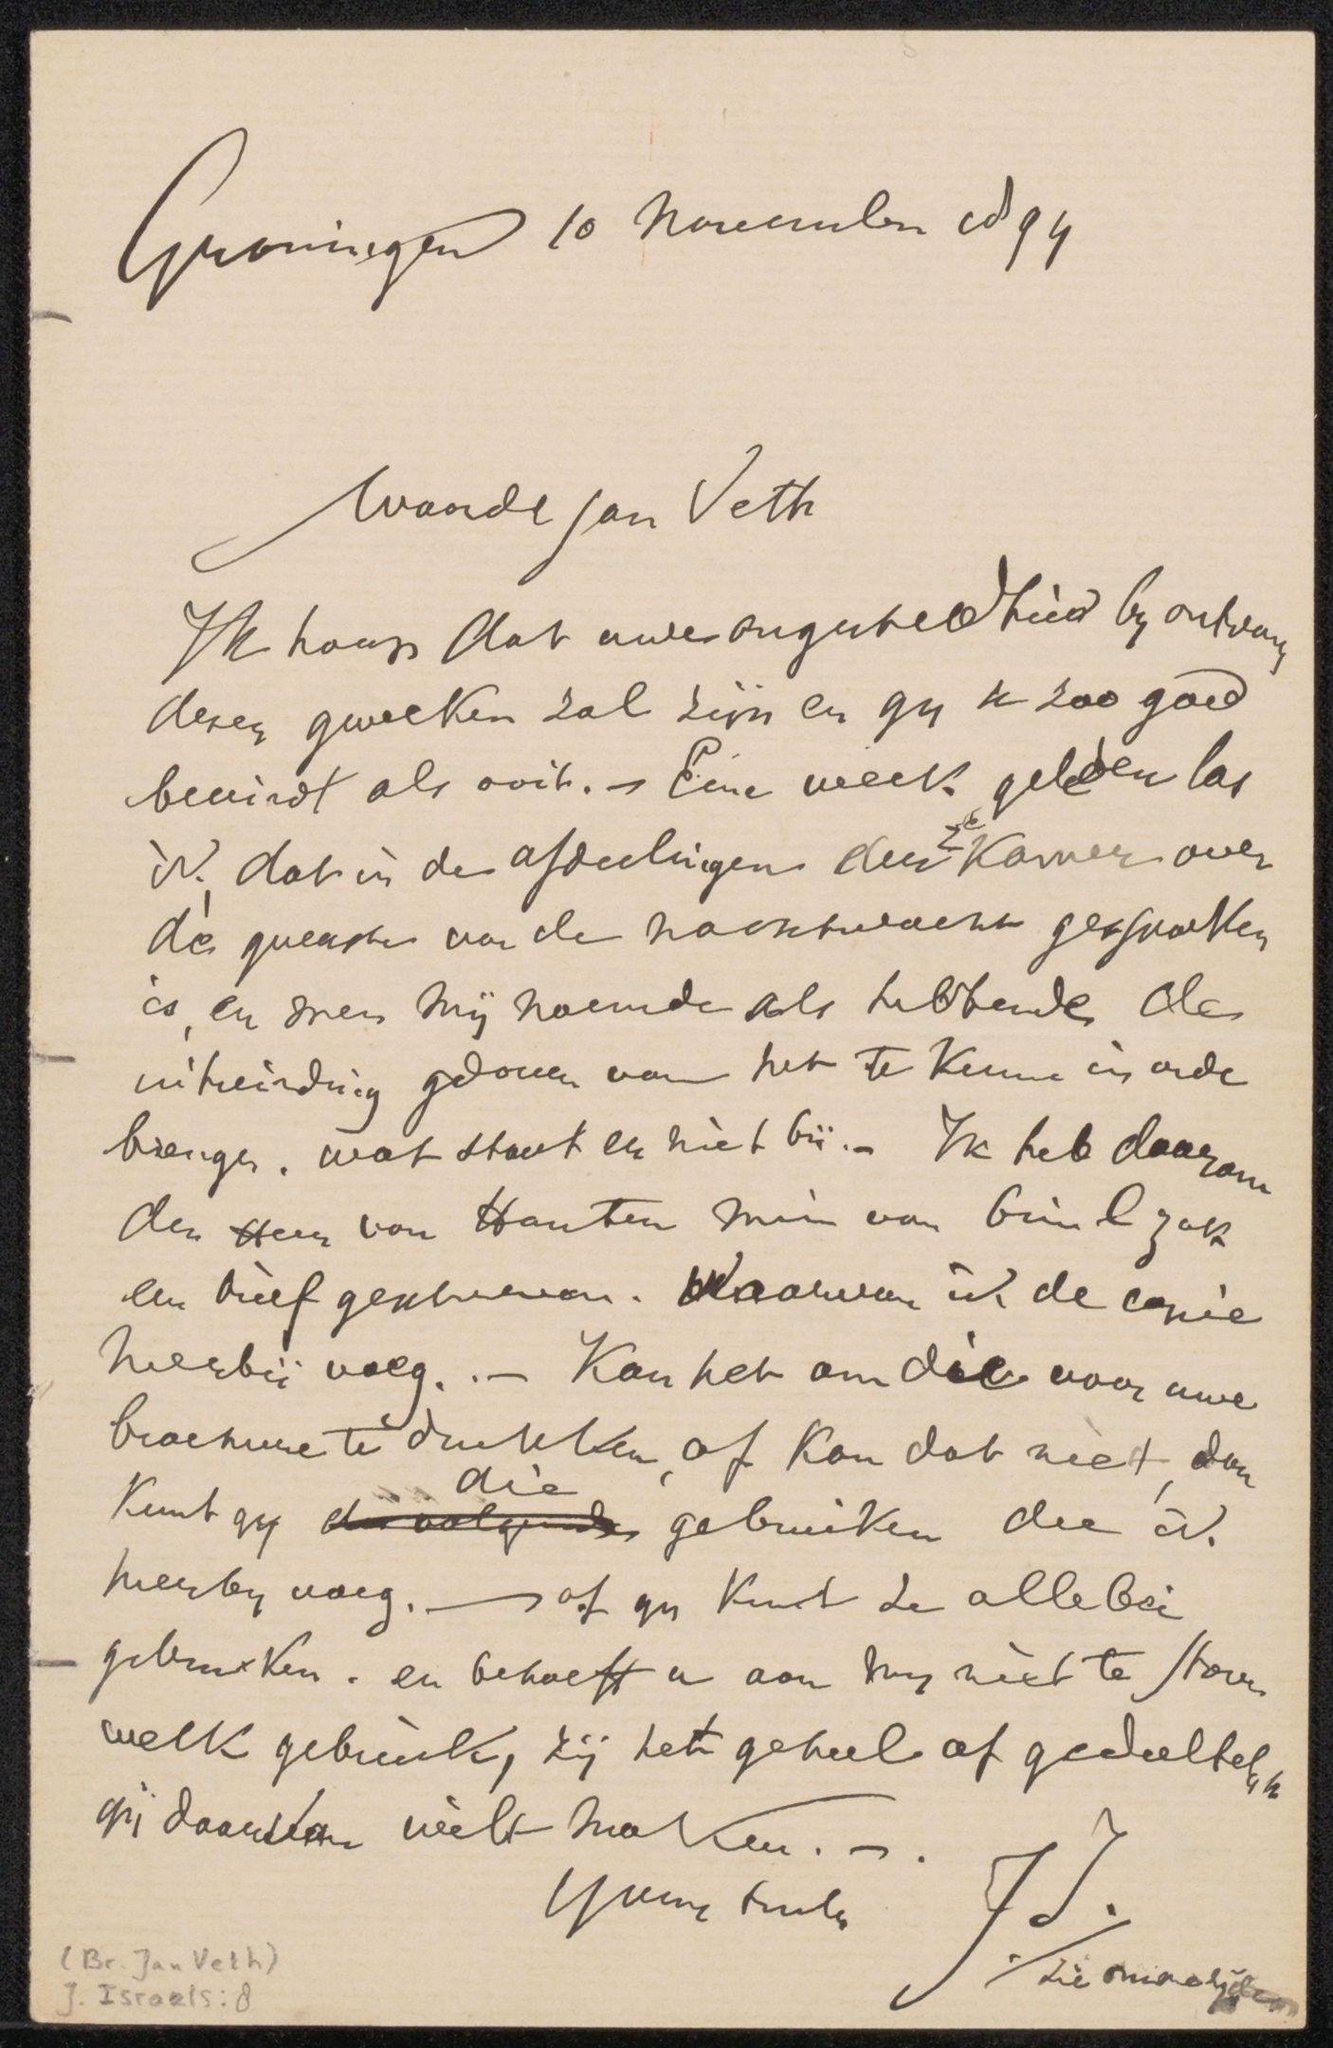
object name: letter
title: Brief aan Jan Veth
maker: jozef israëls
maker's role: draughtsman, painter, print maker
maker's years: 1824-1911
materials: ink, paper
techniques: pen, writing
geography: the hague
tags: johannes bosboom, dordrecht, designer, jan veth, maastricht, jonkheer victor eugène louis de stuers, pierre joseph hubert cuypers, leiden, amsterdam, painter, print maker, draughtsman, rembrandt van rijn, samuel van houten, rijksmuseum amsterdam, painting (including book-illumination, miniature-painting)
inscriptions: collector's mark: ‘RPK’, watermark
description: Vormt doorlopende brief met RP-D-1984-40-J.ISRAELS-9.